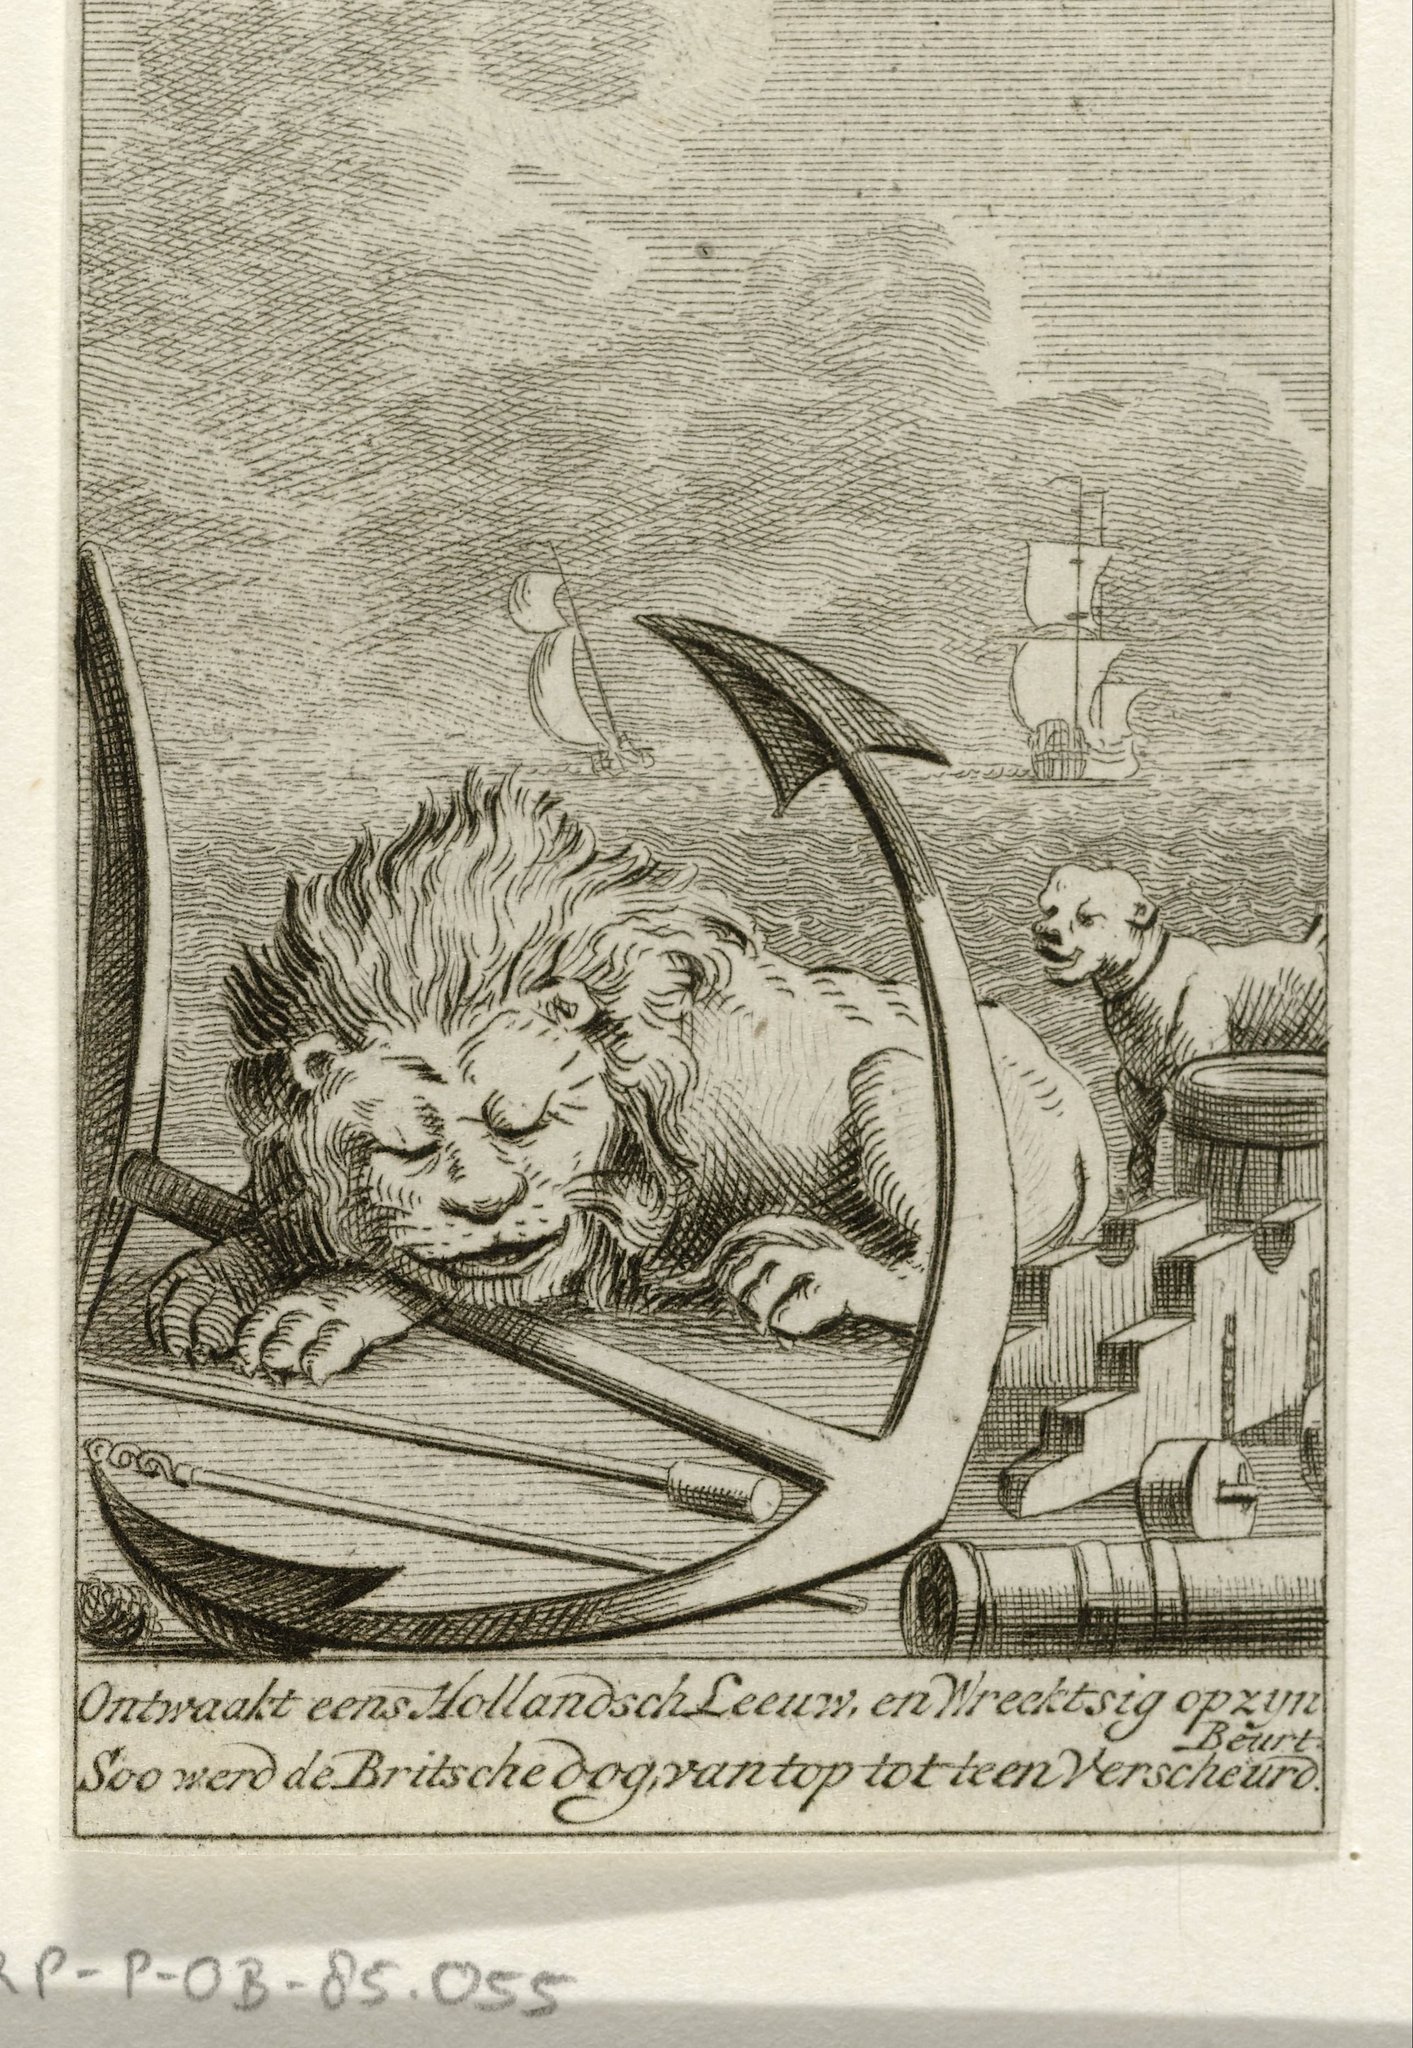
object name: cartoon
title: De Britse Dog verstoort de slapende Hollandse Leeuw, ca. 1780-1783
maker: Anonymous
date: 1780-1783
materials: paper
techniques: engraving, etching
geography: northern netherlands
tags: political caricatures and satires, fourth anglo-dutch war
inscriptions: collector's mark: Lugt 2228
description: Spotprentje waarin de Hollandse Leeuw slapende op een anker wordt verstoord door een Britse Dog. Met tweeregelig onderschrift. Onderdeel van een serie van zes kleine voorstellingen over de spanningen tussen Engeland en Nederland, ca. 1780-1783.